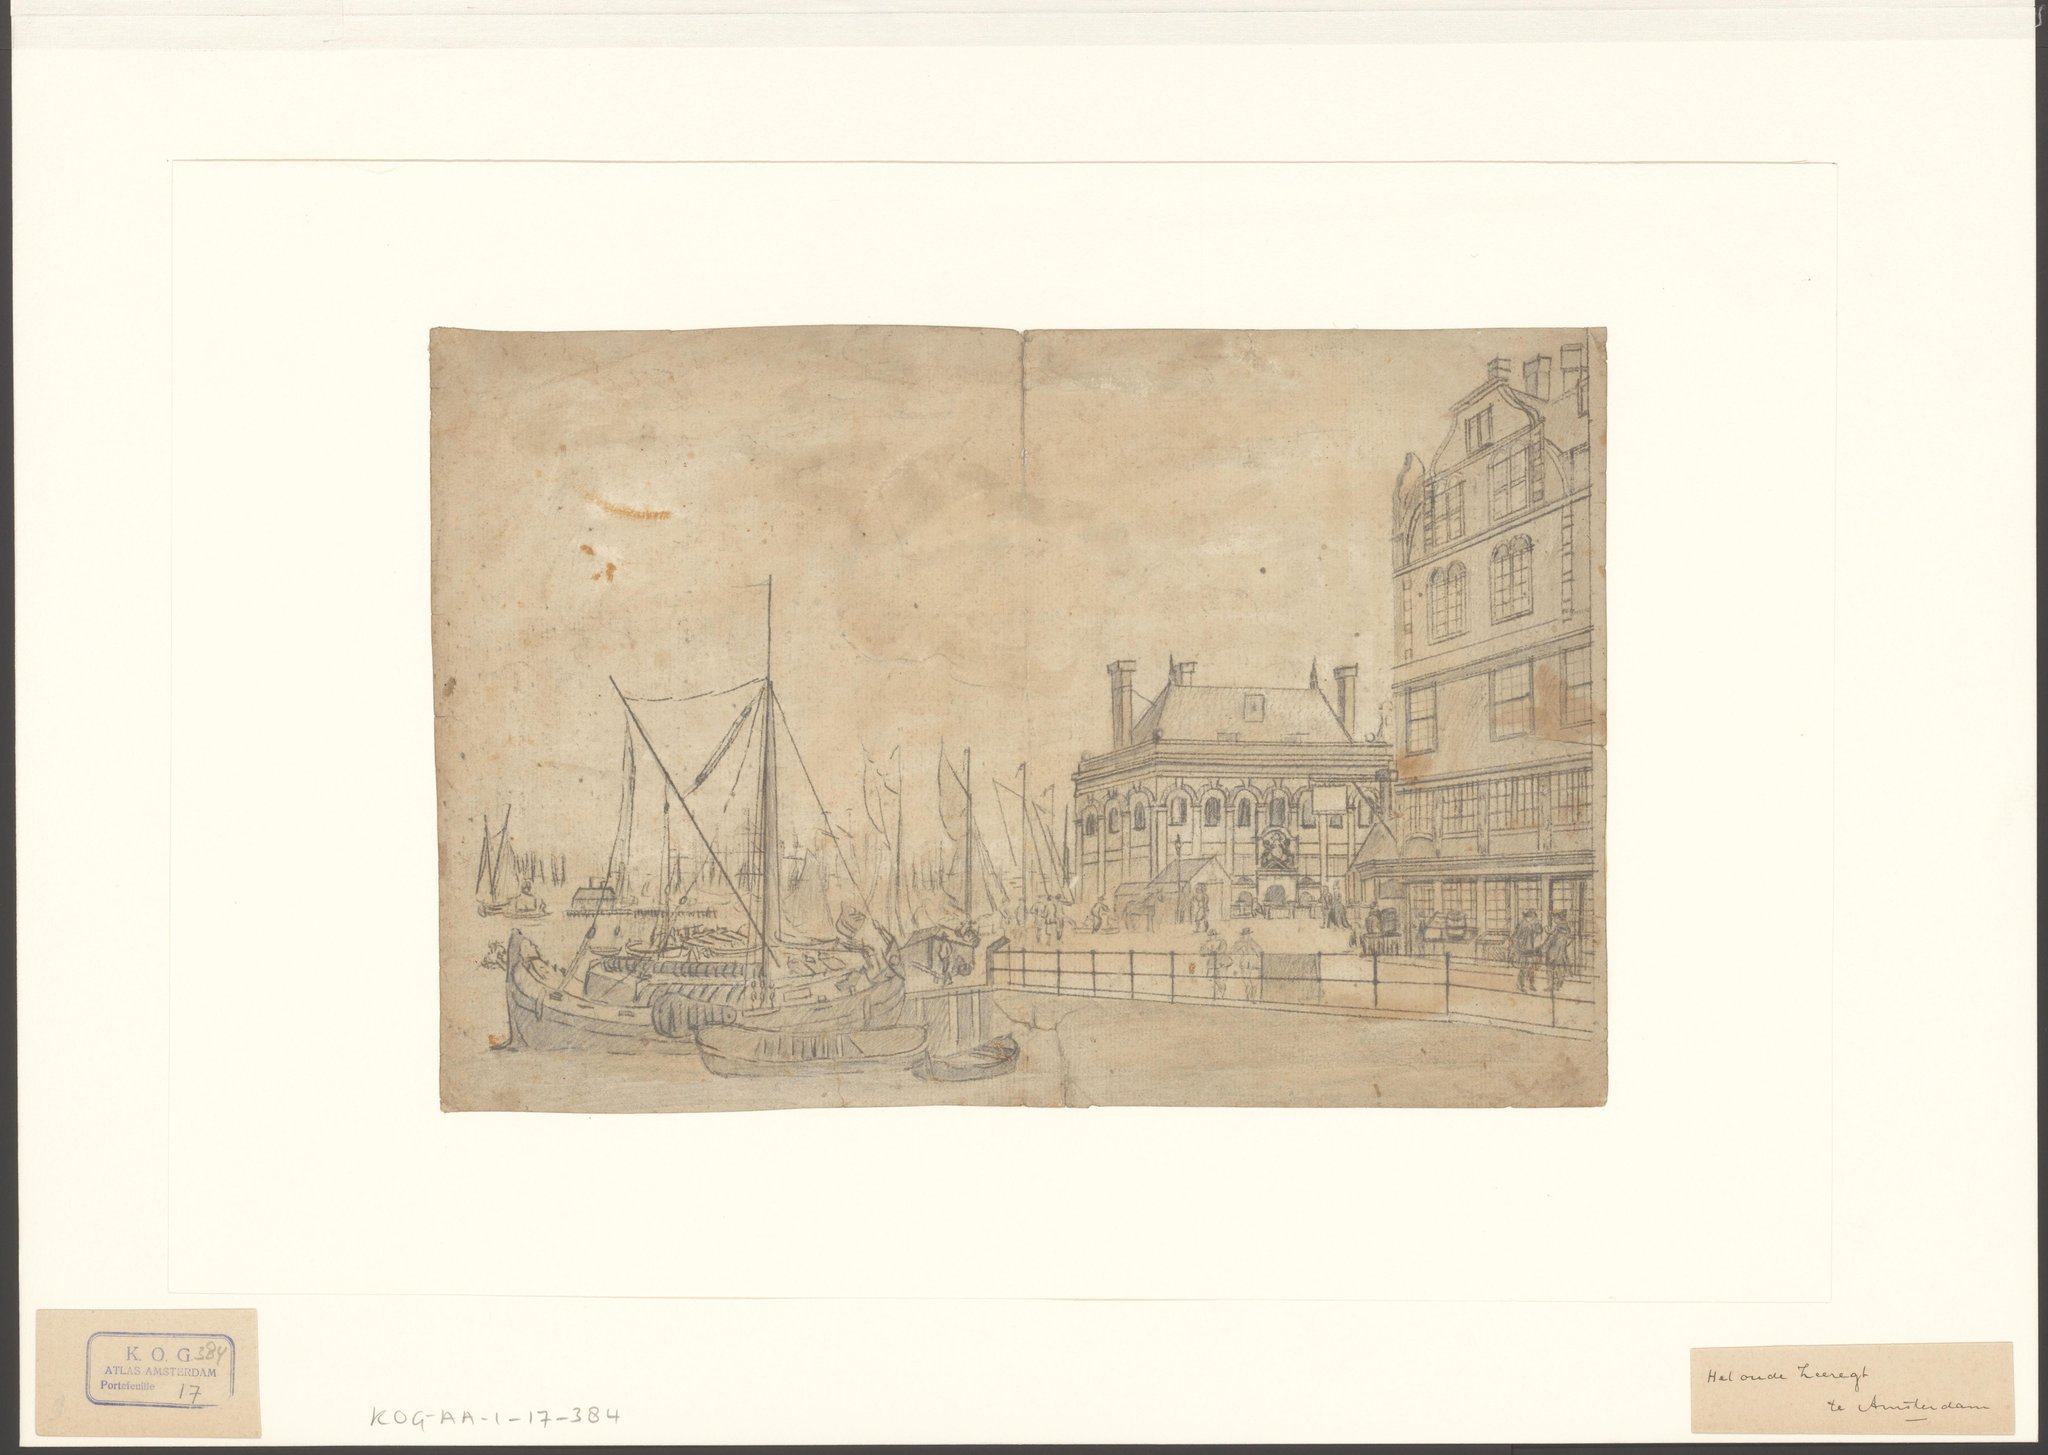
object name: drawing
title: Gezicht op de Kampersteiger aan het IJ, gezien vanaf de Nieuwe Brug naar Zeerecht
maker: Anonymous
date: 1750-1799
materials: paper, pencil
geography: amsterdam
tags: city-view in general; 'veduta', river, street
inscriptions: inscription: ‘Port. 17 / - 384’, inscription: ‘het oude / zeeregt / te Amsterdam’, inscription: ‘het oude Zeeregt / te Amsterdam’, collector's mark: ‘17’ Lugt 1641b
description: Onderwerpsrubriek binnen de Atlas Amsterdam: Vaartuigen en Gebouwen ten dienste der Stedelijke Regeering en Administratie, Stadhuis (Prinsenhof).